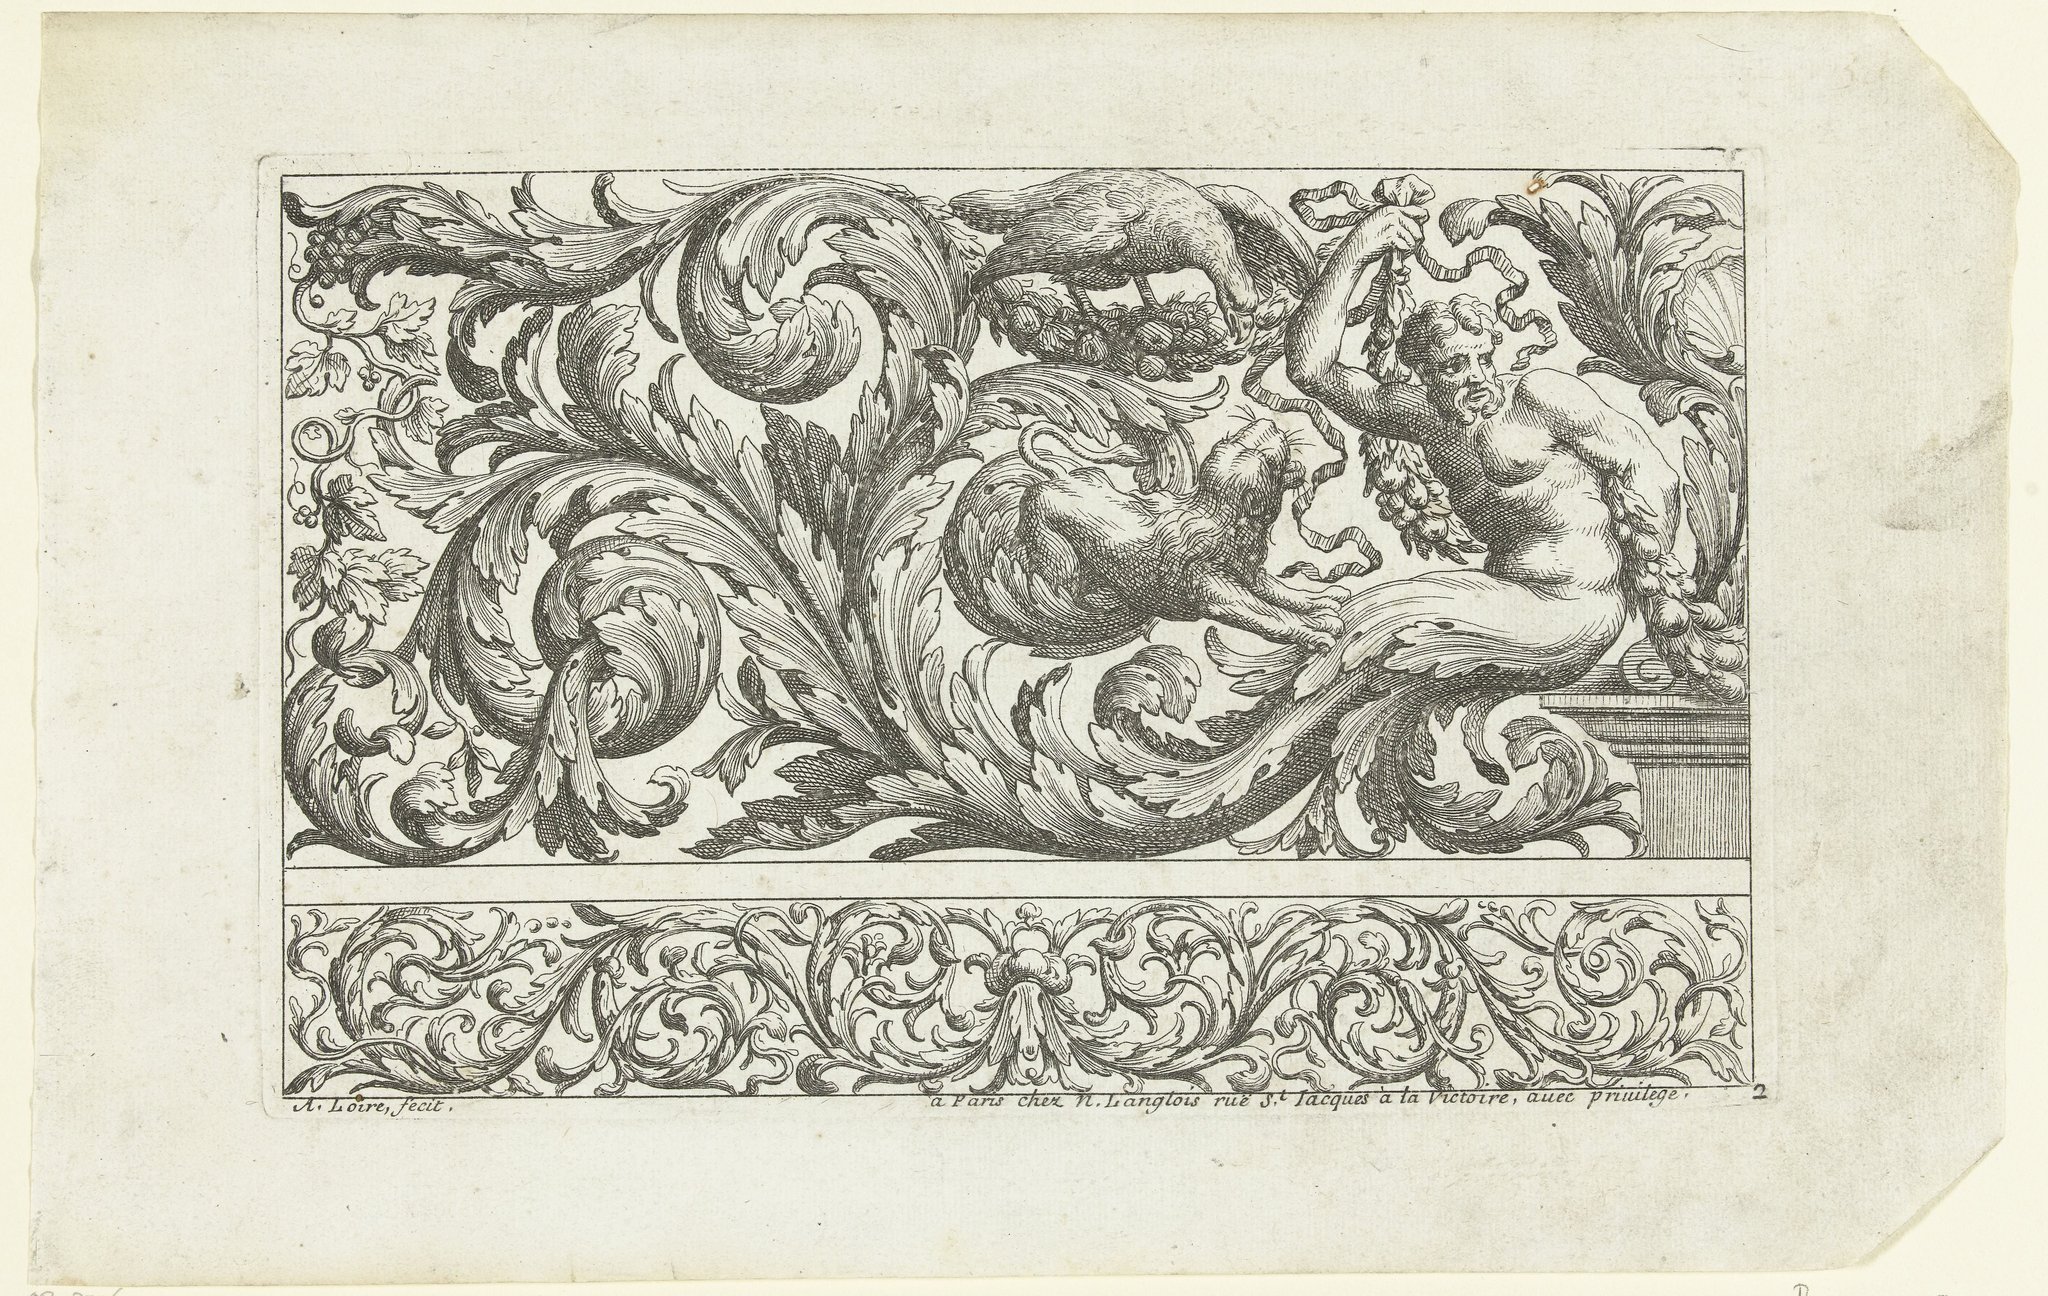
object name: ornament print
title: Friezen met bladranken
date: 1670-1690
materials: paper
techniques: etching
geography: france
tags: predatory birds: eagle, beasts of prey, predatory animals: lion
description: De man, wiens onderlichaam ontspruit uit een bladrank, zit op een voetstuk rechts.